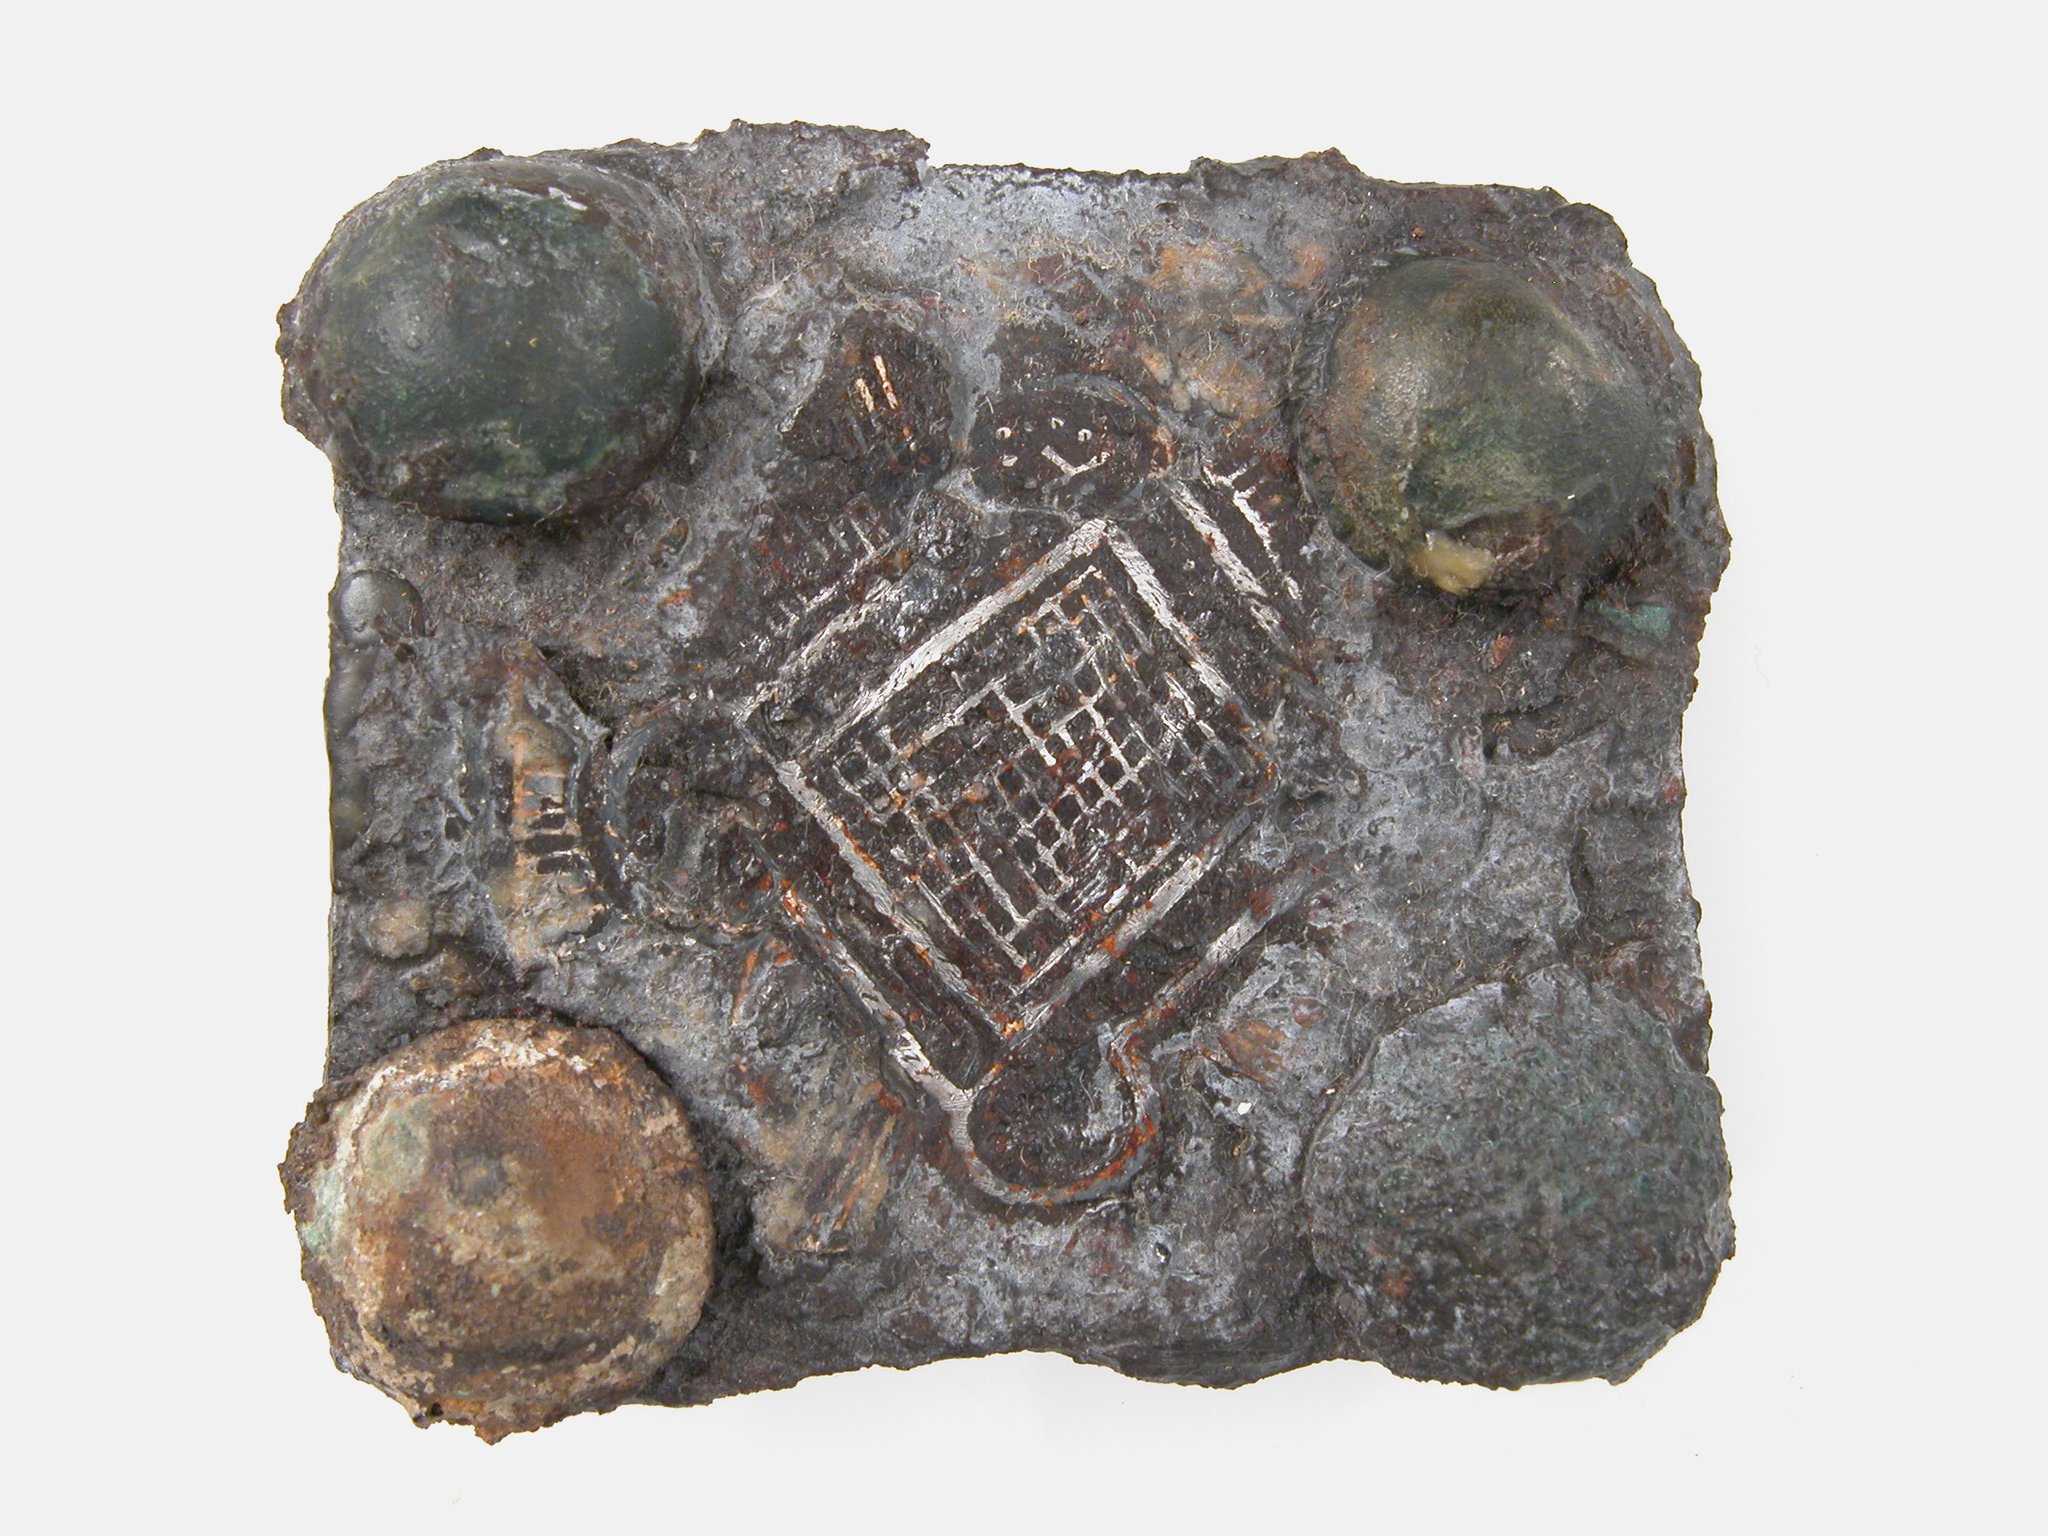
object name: belt plate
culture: frankish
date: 501-700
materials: iron, silver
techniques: inlay